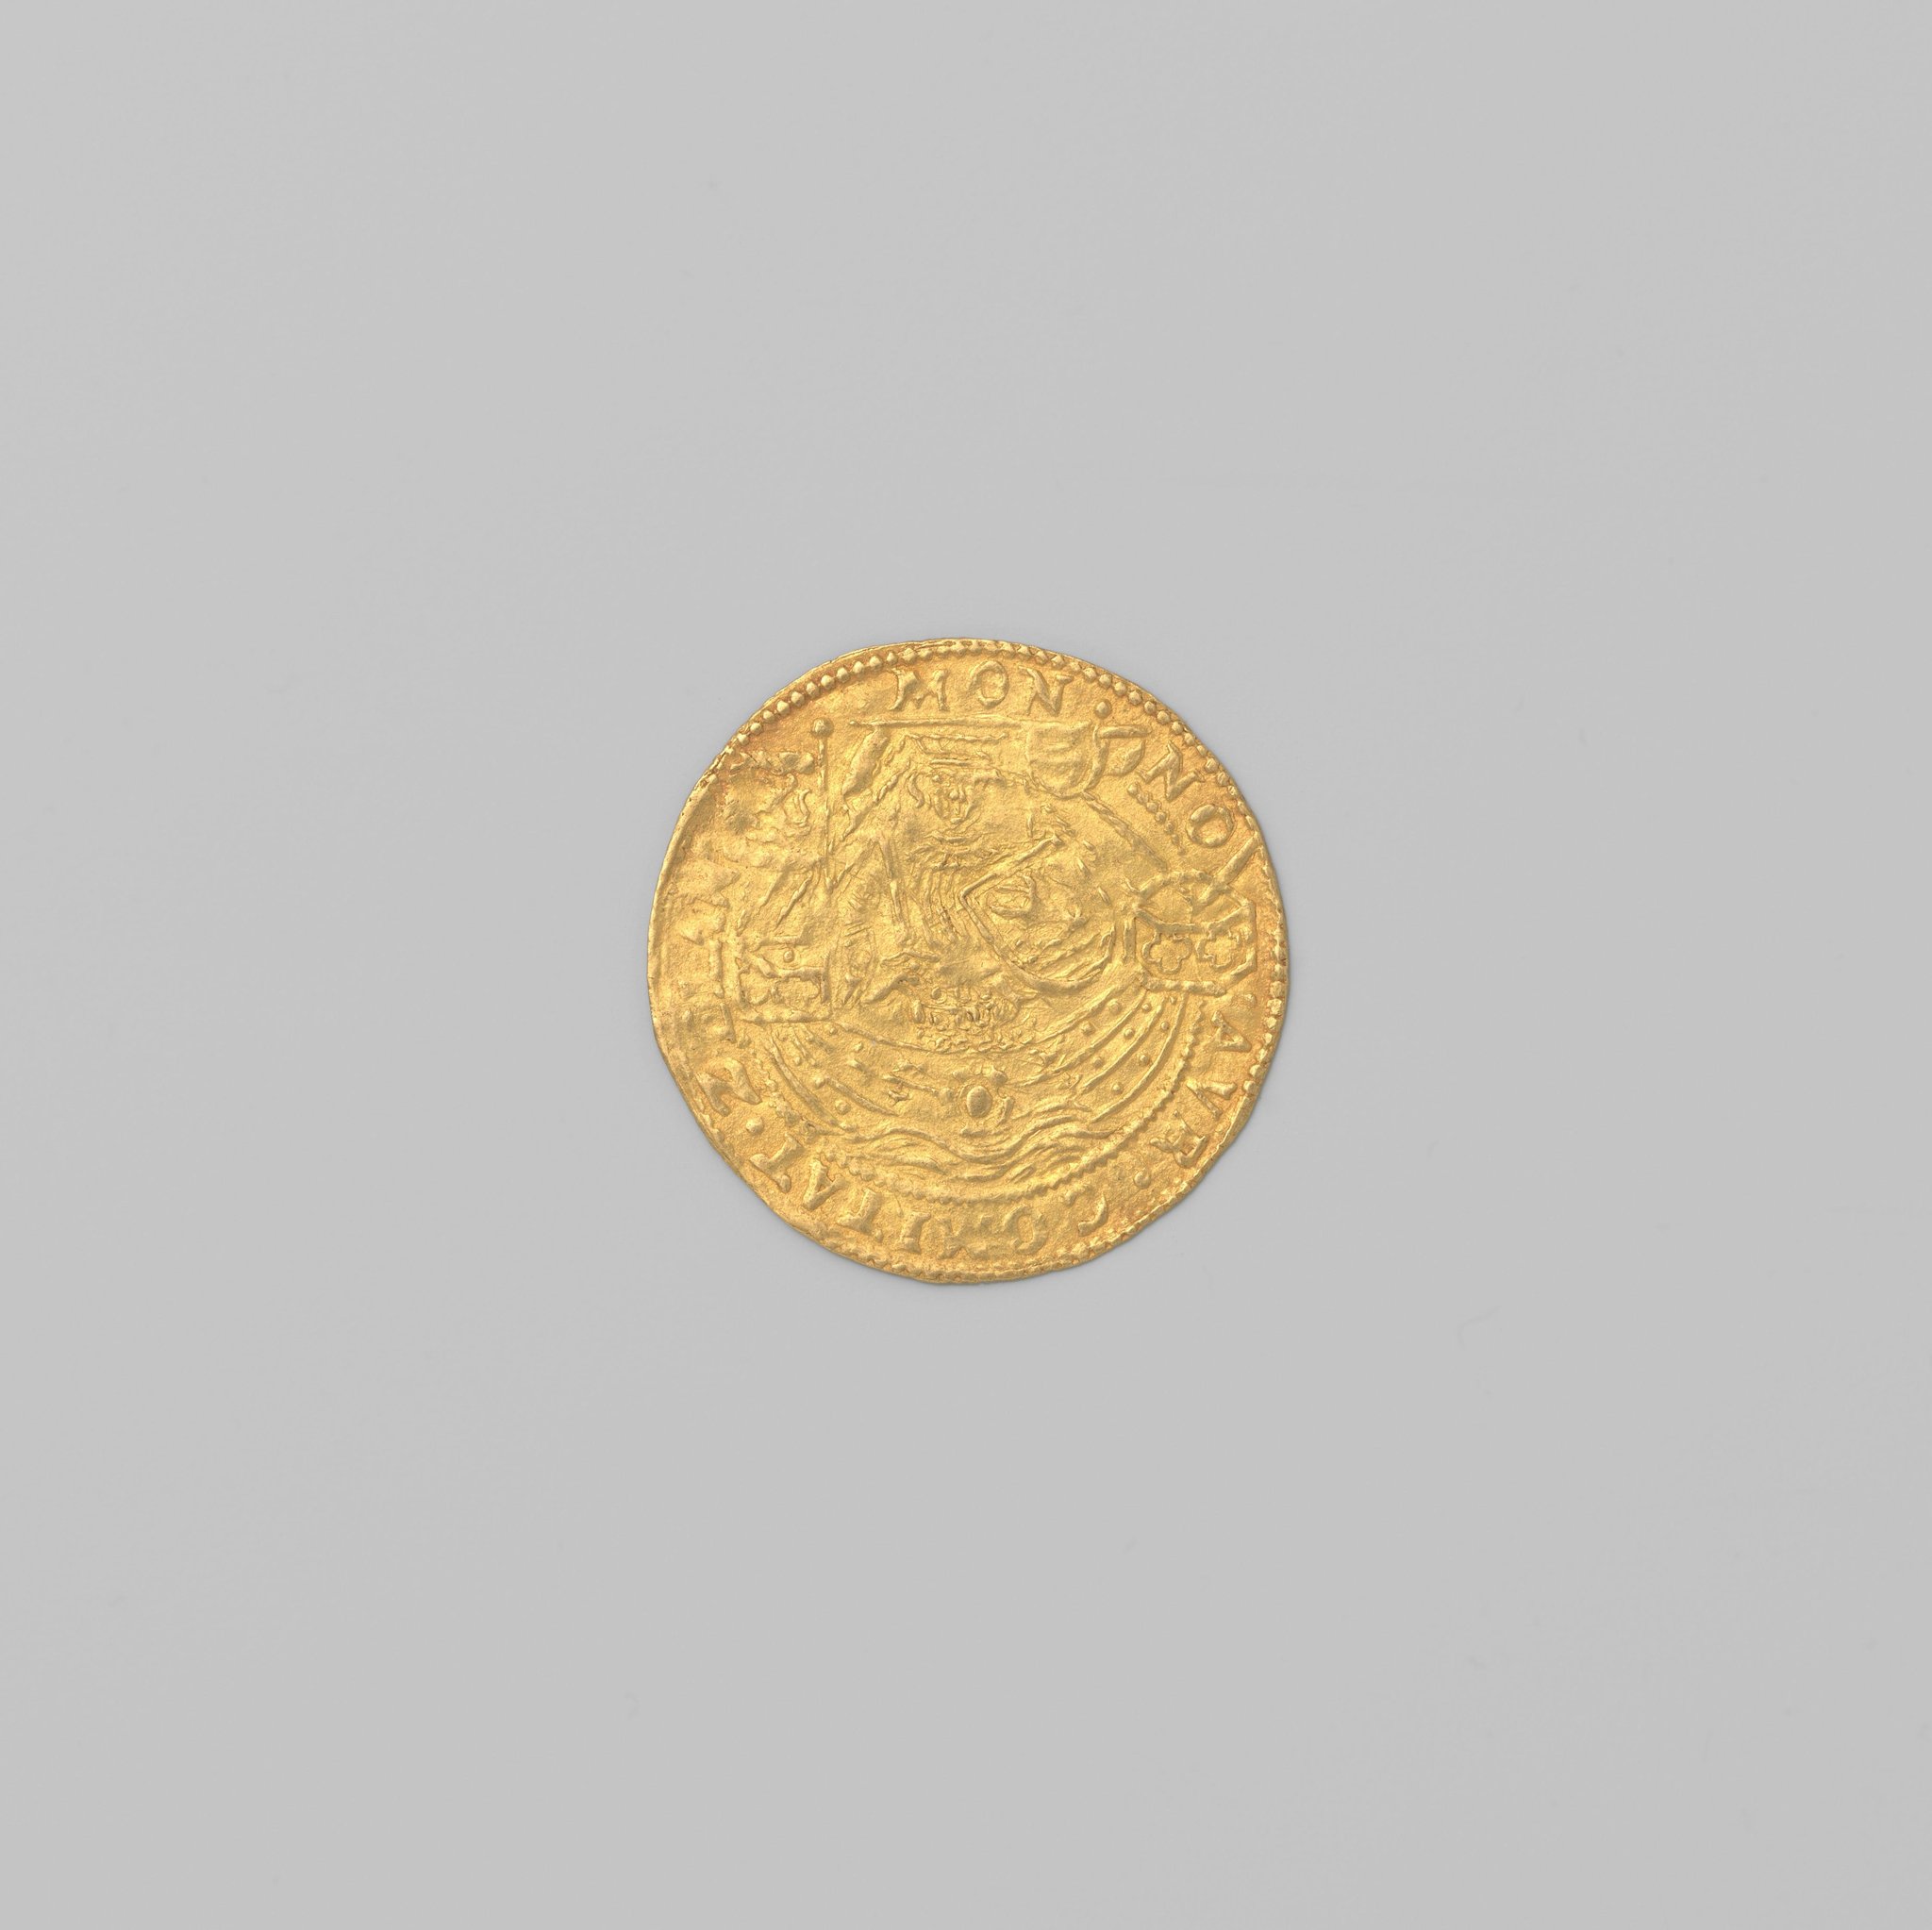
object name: halve rozenobel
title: Halve gouden rozenobel Zeeland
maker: Anonymous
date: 1600-1602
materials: gold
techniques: striking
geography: europe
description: Gouden handelsmunt afkomstig uit Nederlandse muntvondst.